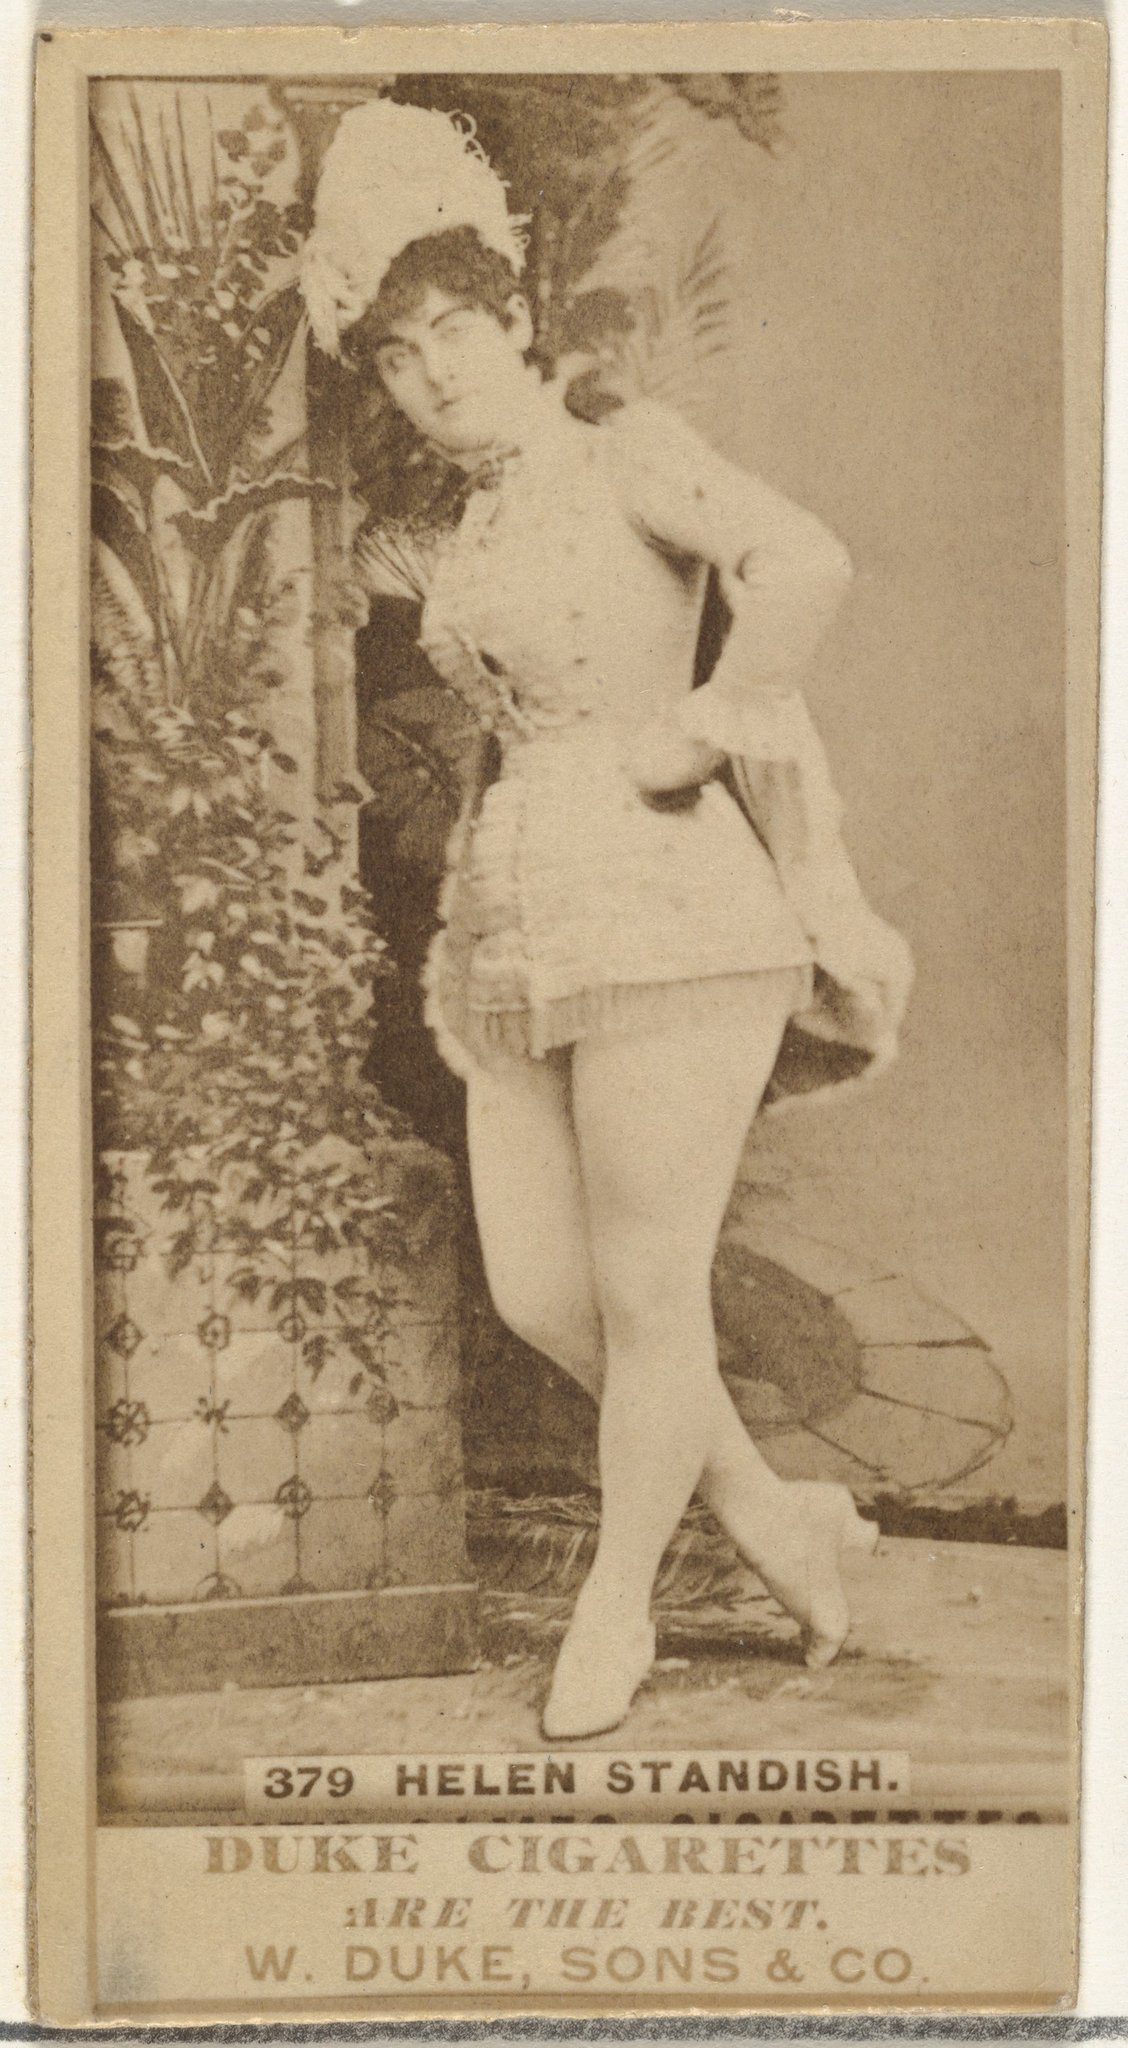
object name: photograph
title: Card Number 379, Helen Standish, from the Actors and Actresses series (N145-7) issued by Duke Sons & Co. to promote Duke Cigarettes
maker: w. duke, sons & co.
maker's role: publisher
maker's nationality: american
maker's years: 1870-1920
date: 1880-1889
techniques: albumen silver print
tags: portraits,women,actresses